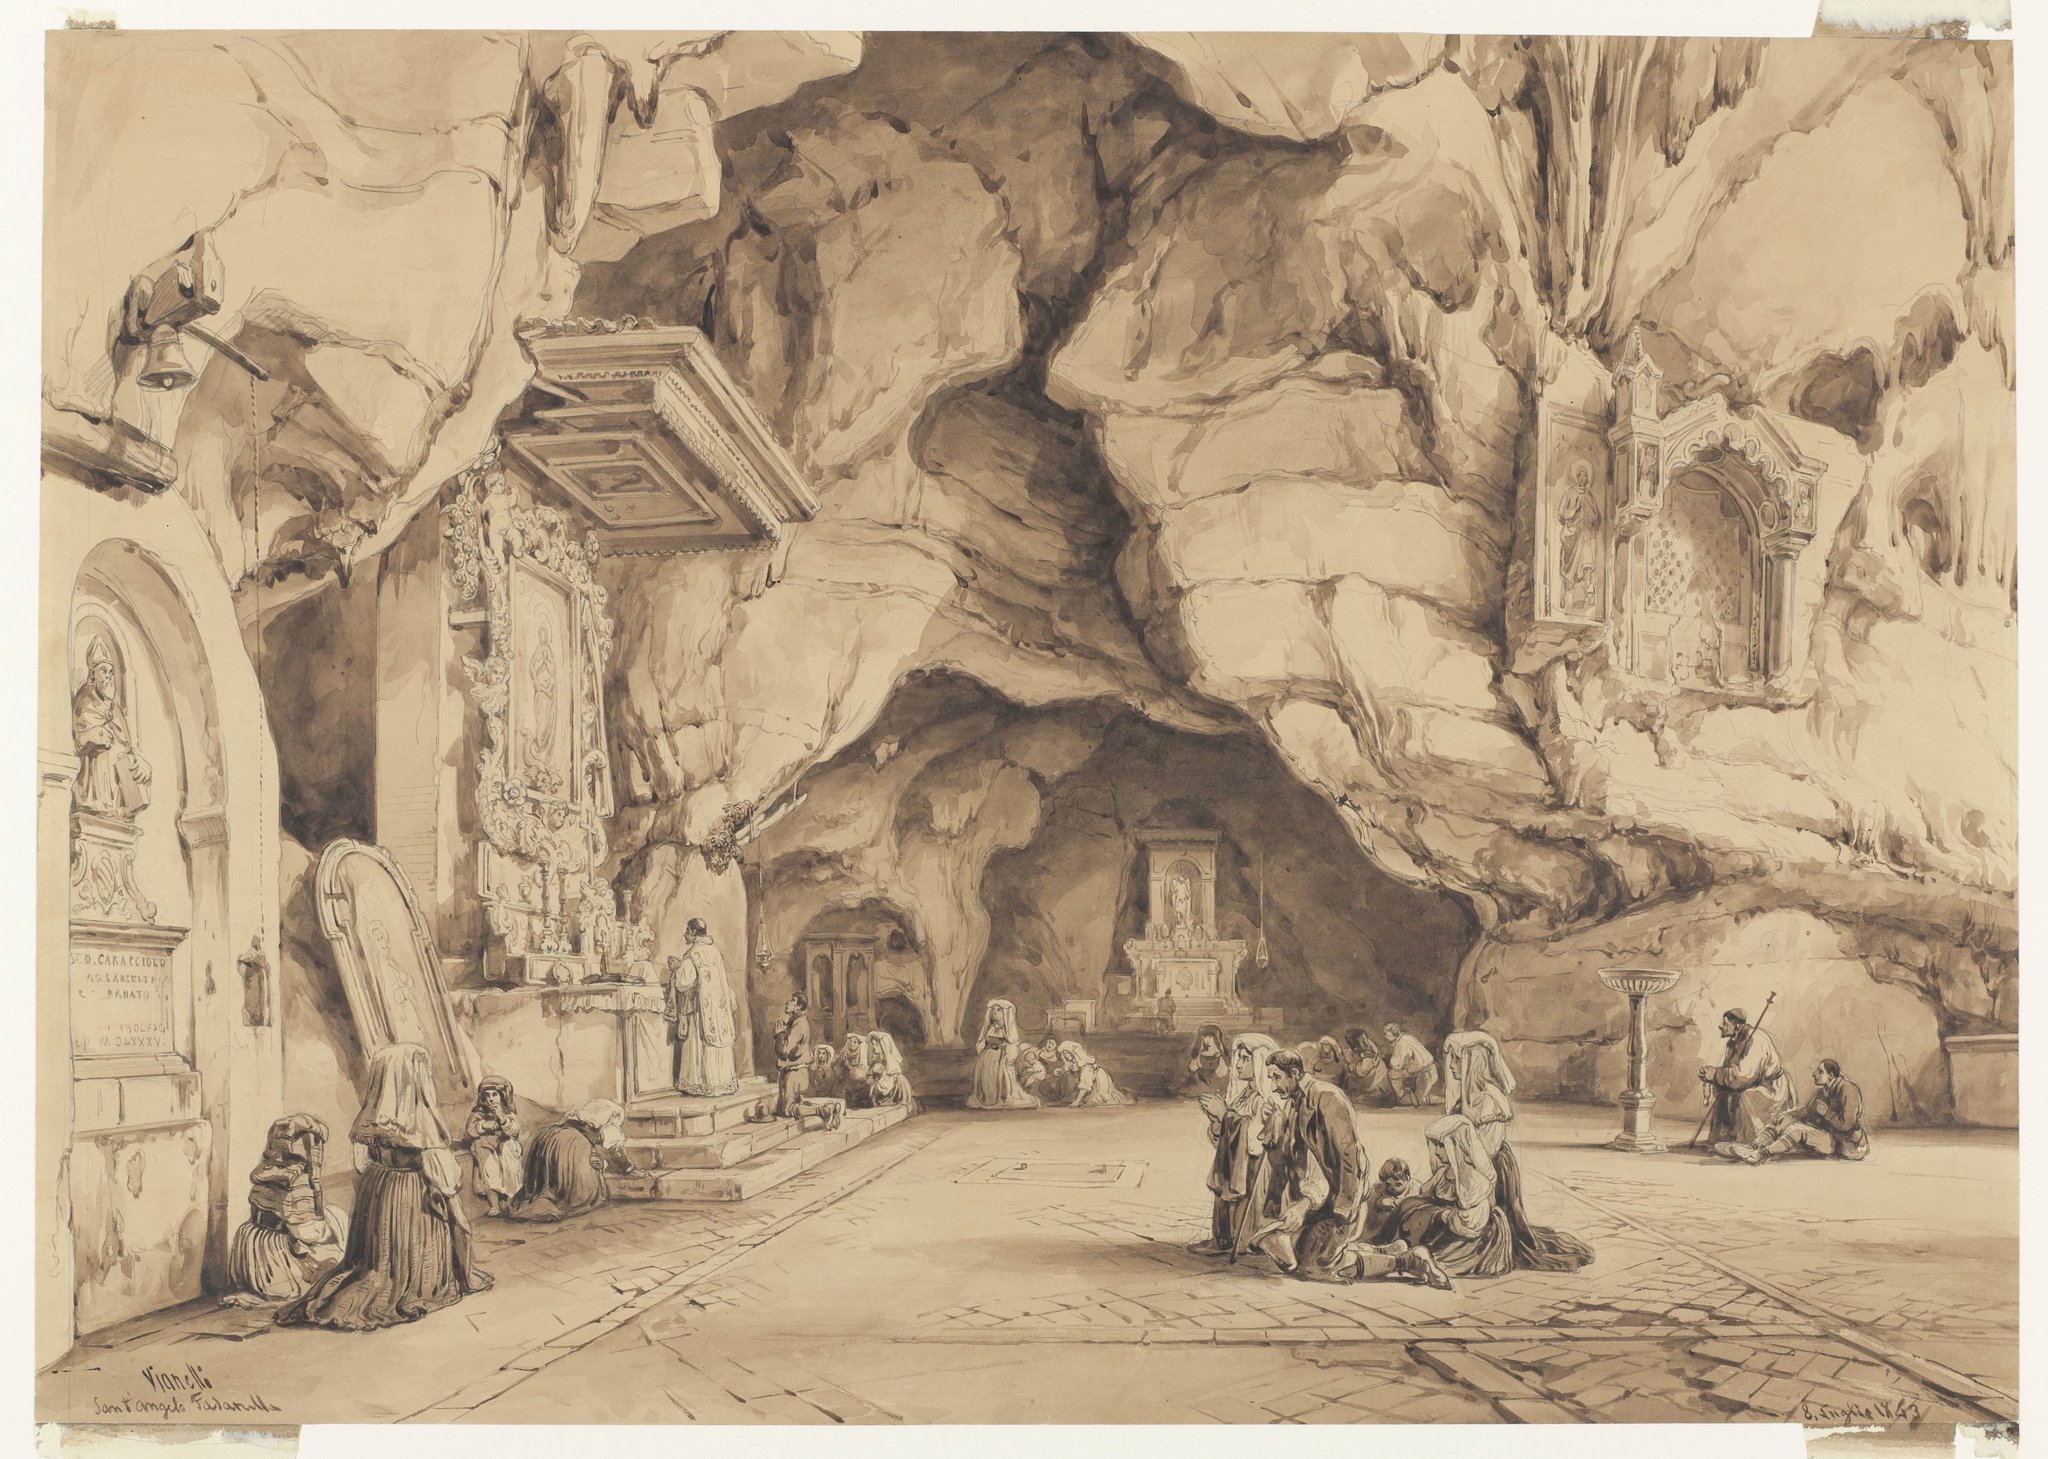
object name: drawing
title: Figuren in de rotskapel van Sant'Angelo Fasanella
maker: achille vianelli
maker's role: draughtsman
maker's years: 1803-1894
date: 1843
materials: paper, pencil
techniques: brush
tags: church (exterior), (private) prayer; 'oratione', 'preghiere', 'preghiere a dio' (ripa), cave, grotto, italy